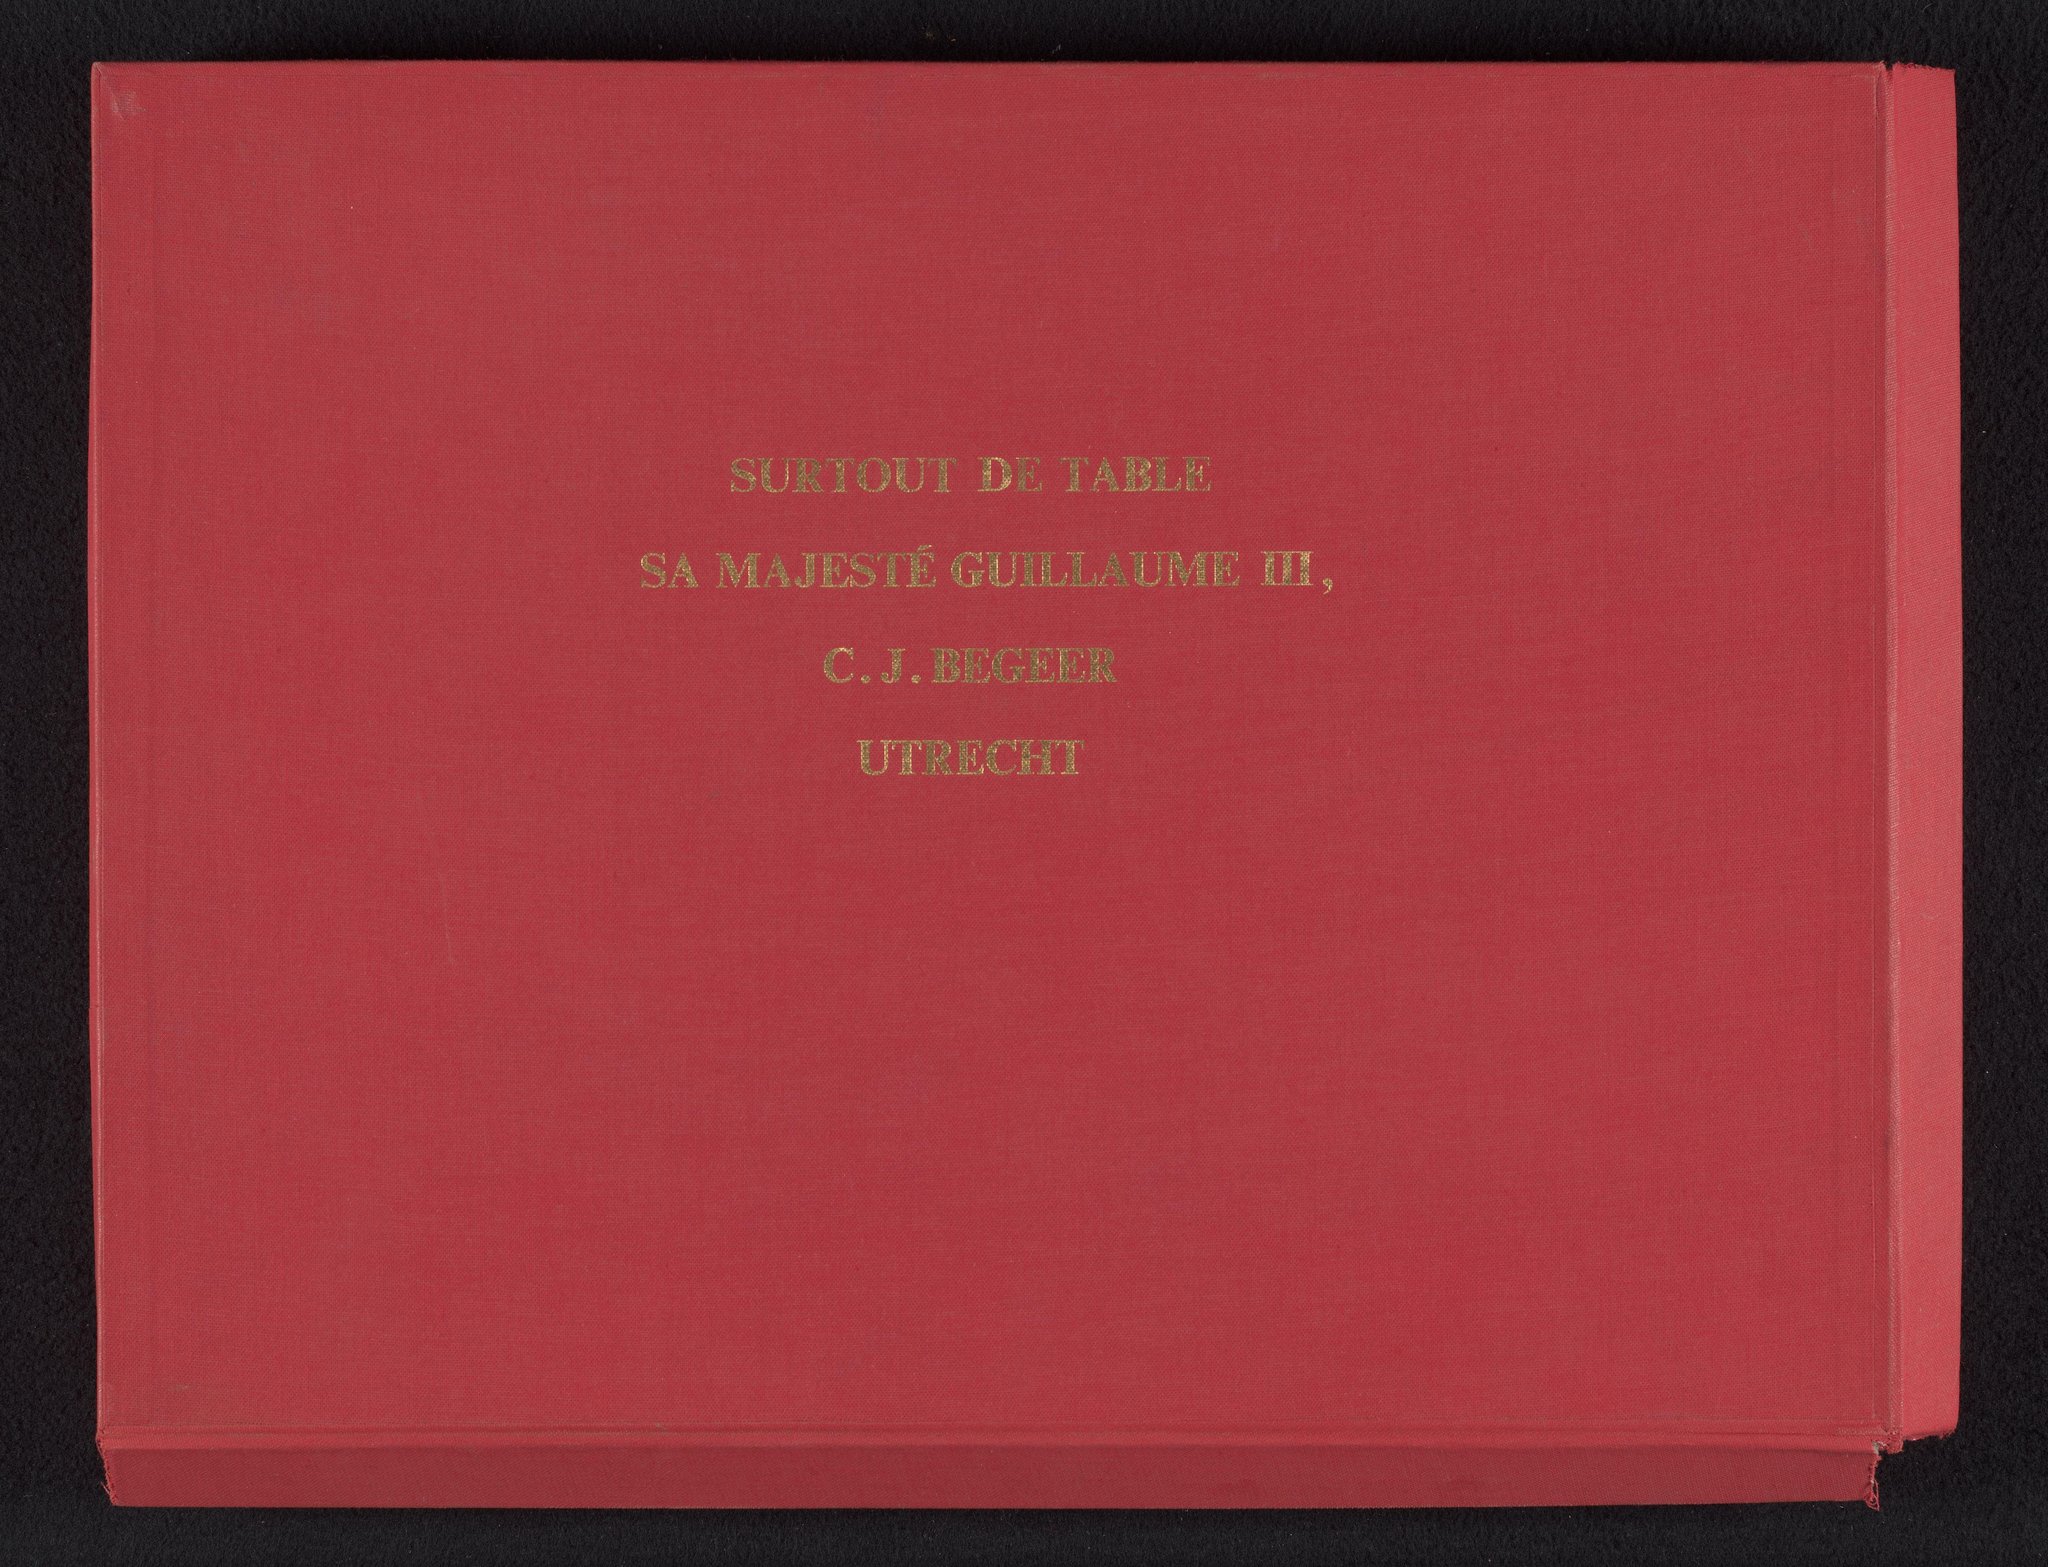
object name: cassette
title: Cassette voor de serie 'Surtout de table sa exécuté par ordre de Sa Majesté Guillaume III'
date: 1889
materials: cardboard, linen, paper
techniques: printing, etching, intaglio, letterpress printing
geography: utrecht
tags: centre-piece, epergne, 'surtout', 'milieu-de-table', dinner-service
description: Cassette met daarin: twee gevouwen tekstbladen en de set van veertien prenten. Elke prent ligt in een gevouwen blad met daarop de naam van het afgebeelde object en een bladzijde tekst. Van drie van de prenten (waarvan één met het gevouwen tekstblad) is een tweede exemplaar aanwezig.